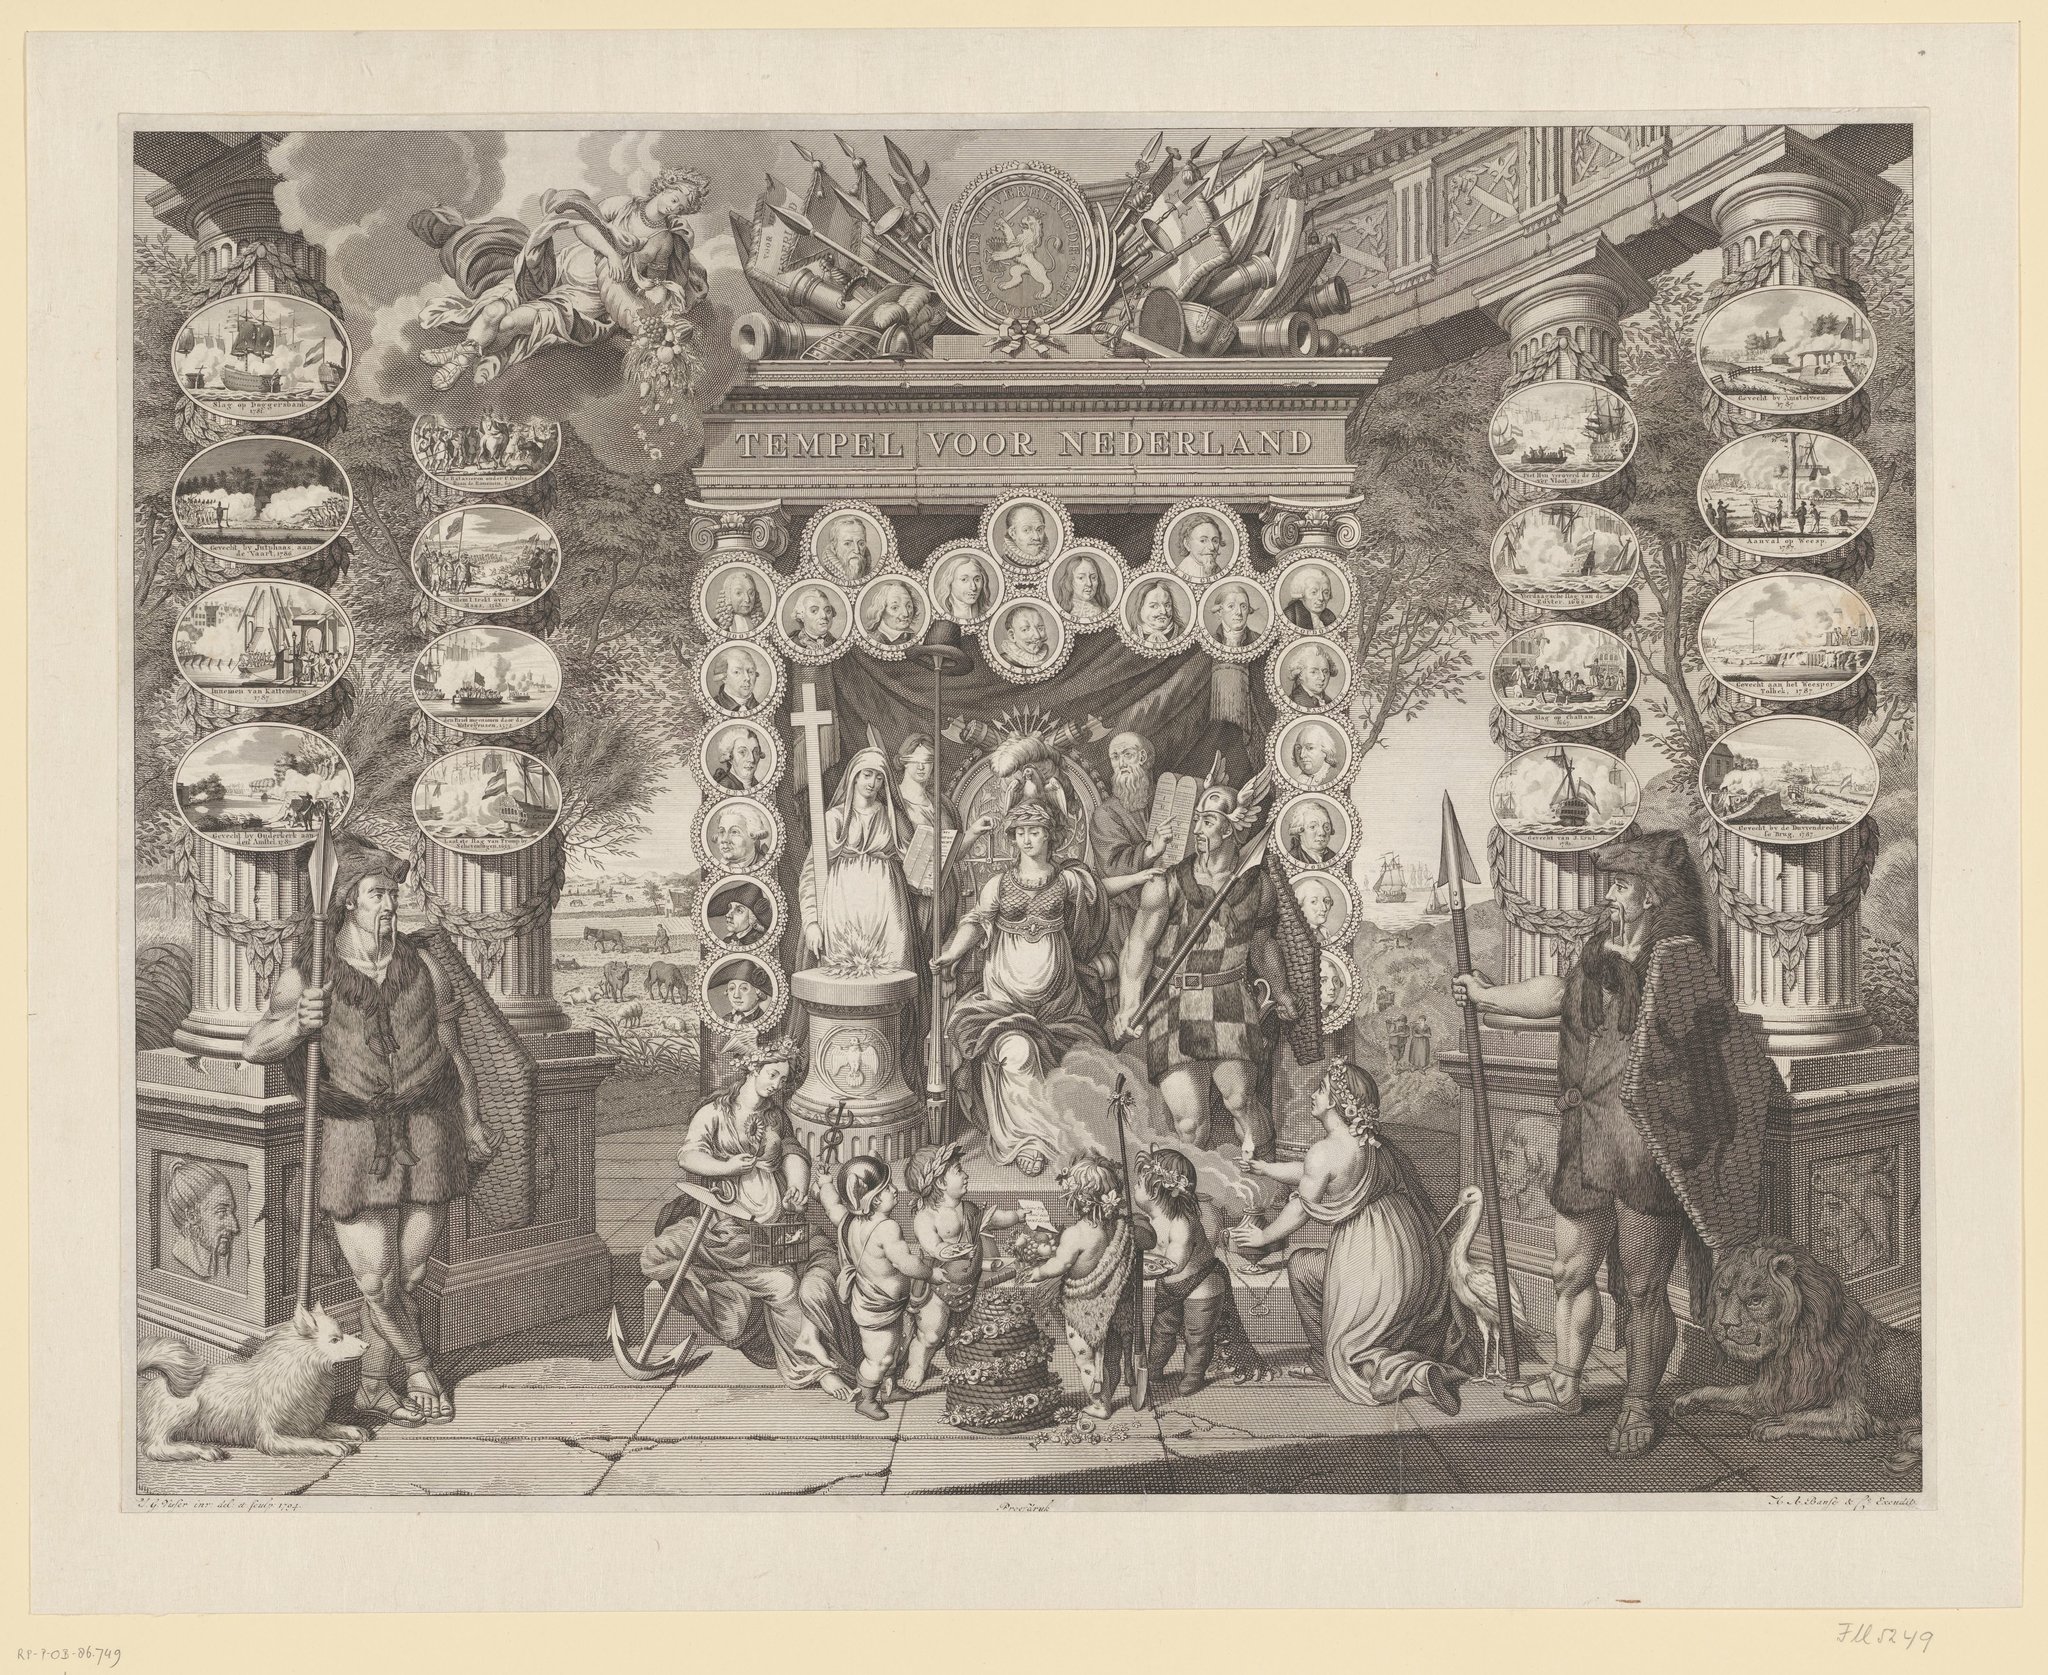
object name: print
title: Tempel voor Nederland, 1794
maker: jan gerritsz. visser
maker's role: print maker, publisher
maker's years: 1745-1821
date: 1794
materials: paper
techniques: engraving, etching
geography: amsterdam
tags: justice, 'justitia'; 'giustitia divina' (ripa) ~ one of the four cardinal virtues, hope, 'spes'; 'speranza divina e certa' (ripa) ~ one of the three theological virtues, allegorical representations ~ religion; 'religione', 'religione de ss. mauritio e lazaro', 'religione vera christiana' (ripa), bee-hive, extinct, 'historical' peoples, freedom, liberty; 'libertà' (ripa) (+ abstract concept represented by female figure), moses on mount sinai with the tables of the law (exodus 24:9-18, 31:18)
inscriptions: collector's mark: Lugt 2228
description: Allegorisch monument in de vorm van een tempel met centraal de tronende Bataafse Vrijheid tussen Godsdienst, Rechtvaardigeid, Mozes met de wetstafelen en een Batavier. Het voorportaal van de tempel is behangen met portretten van historische helden en patriotten. Voor de troon de Hoop en de Dankbaarheid met vier kinderen (Koophandel, Kunst, Landbouw en Visserij) met een bijenkorf. Links en rechts van de tempel staan twee Batavieren als wachters. Ter weerszijden zuilen waaraan medaillons hangen met voorstellingen van belangrijke gebeurtenisen uit de vaderlandse geschiedenis. Bij de prent behoort een verklaring.